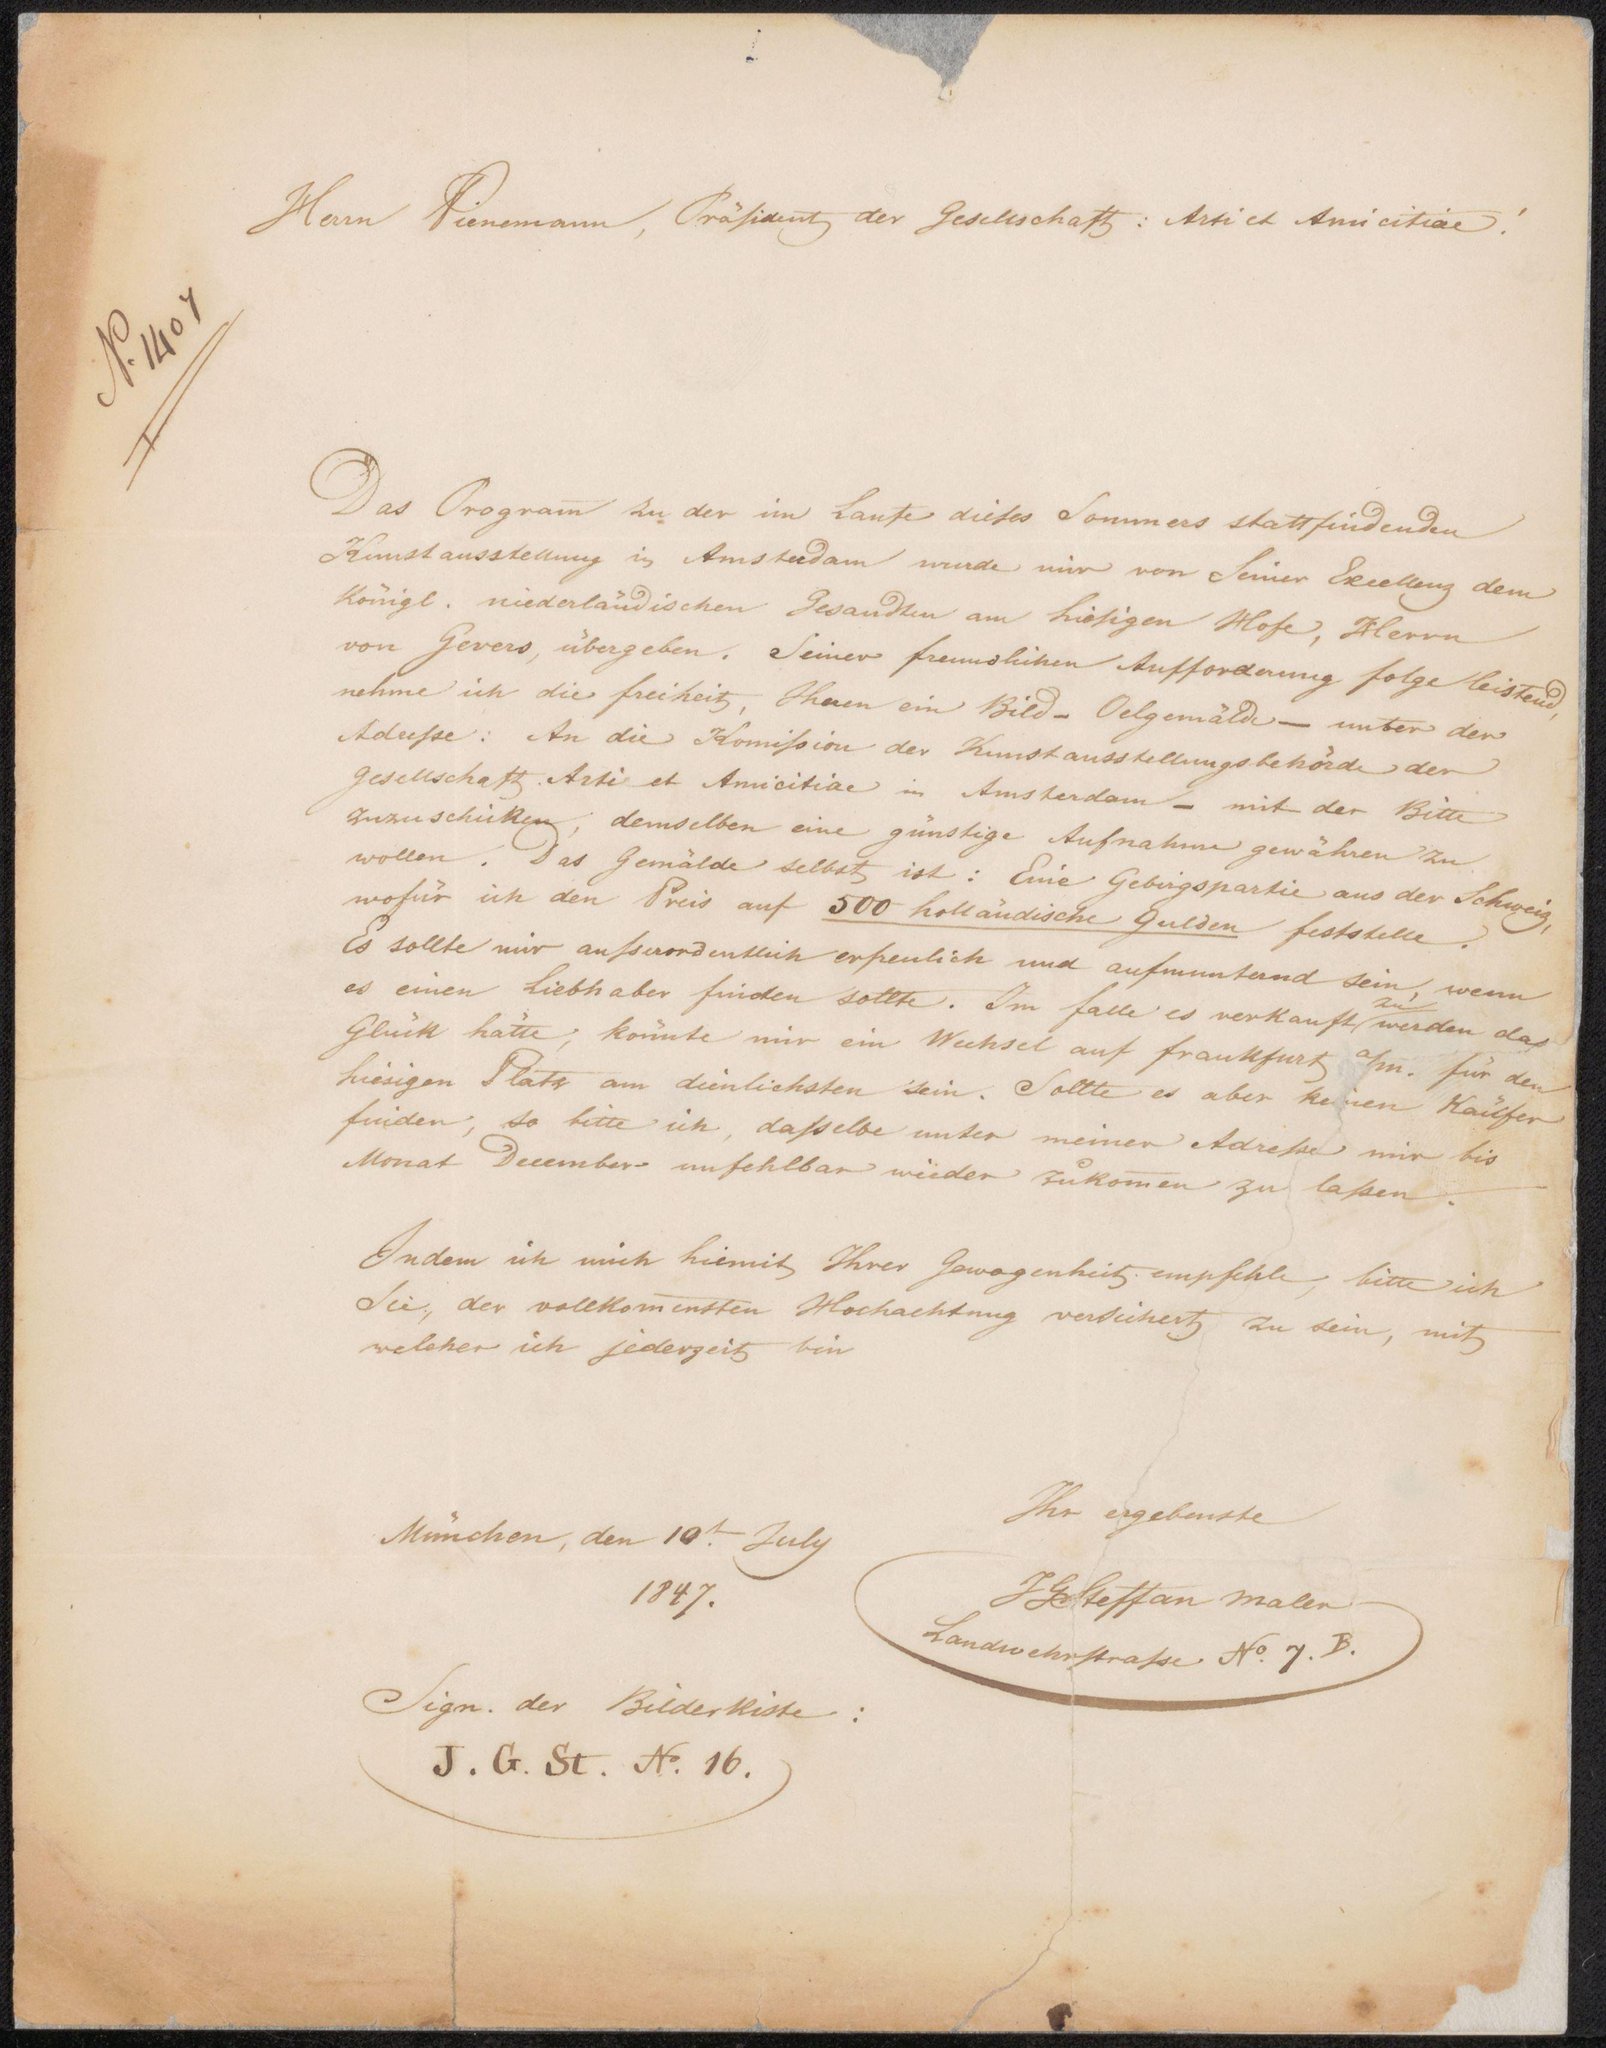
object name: letter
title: Brief aan Nicolaas Pieneman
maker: johann gottfried steffan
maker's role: painter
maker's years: 1815-1905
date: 1847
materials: ink, paper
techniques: pen, writing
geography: munich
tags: amsterdam, painter, print maker, draughtsman, nicolaas pieneman, the hague, painting (including book-illumination, miniature-painting), exhibition ~ art, money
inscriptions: watermark